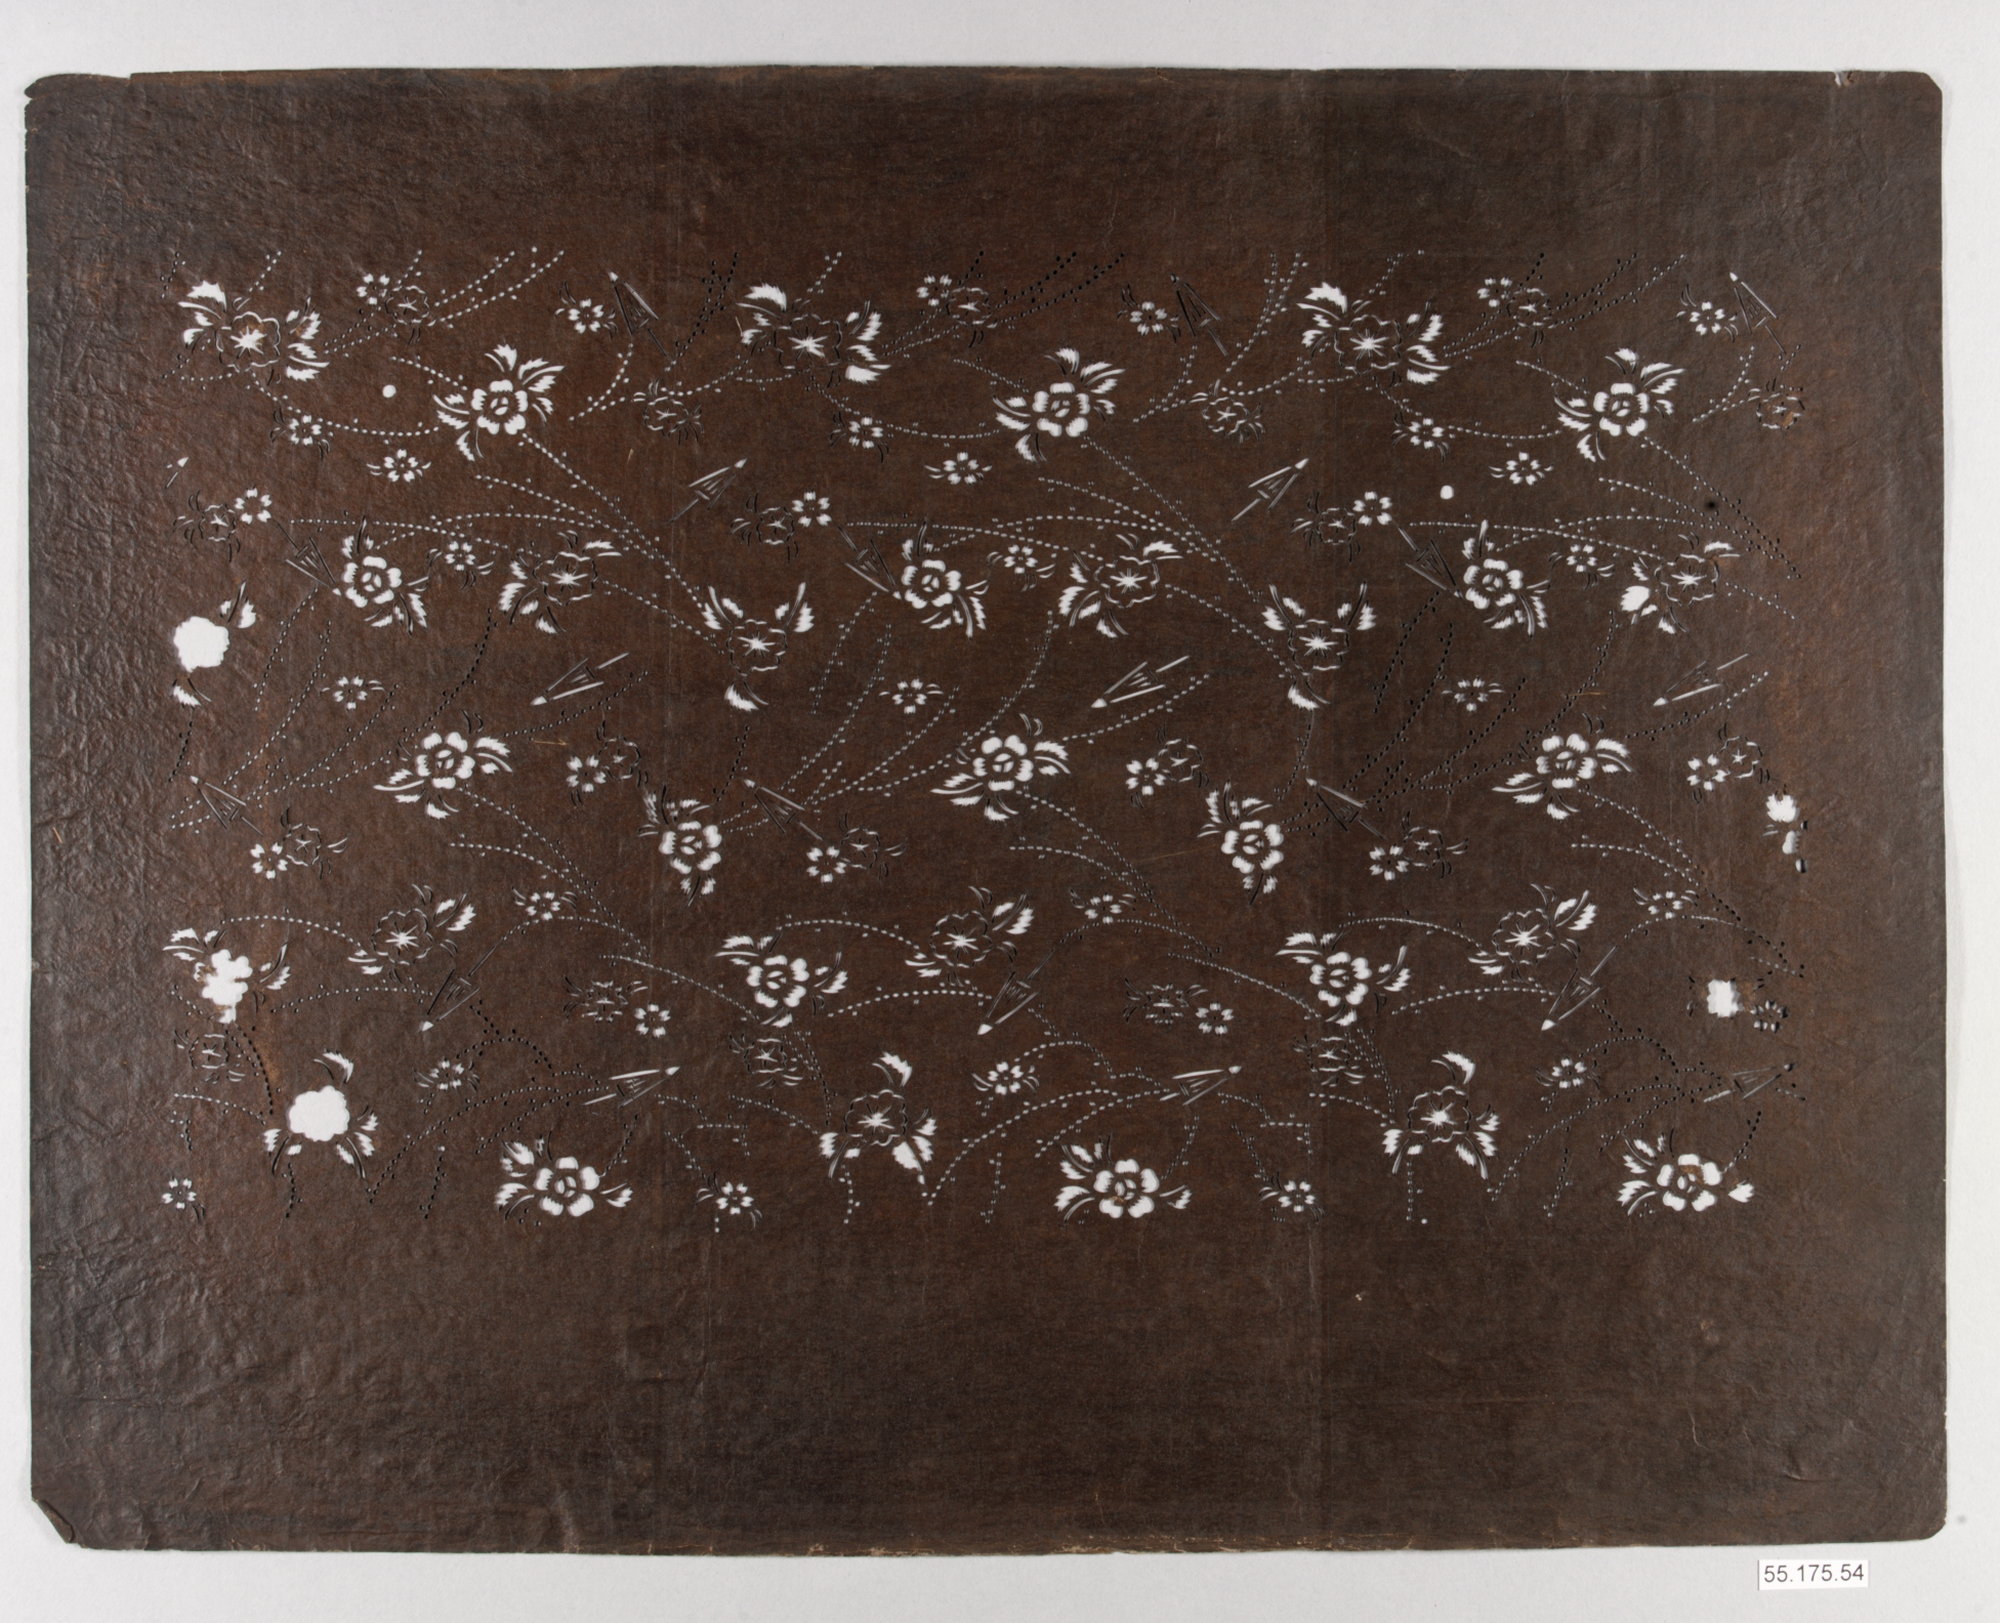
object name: stencil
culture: japanese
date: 1801-1900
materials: paper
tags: flowers